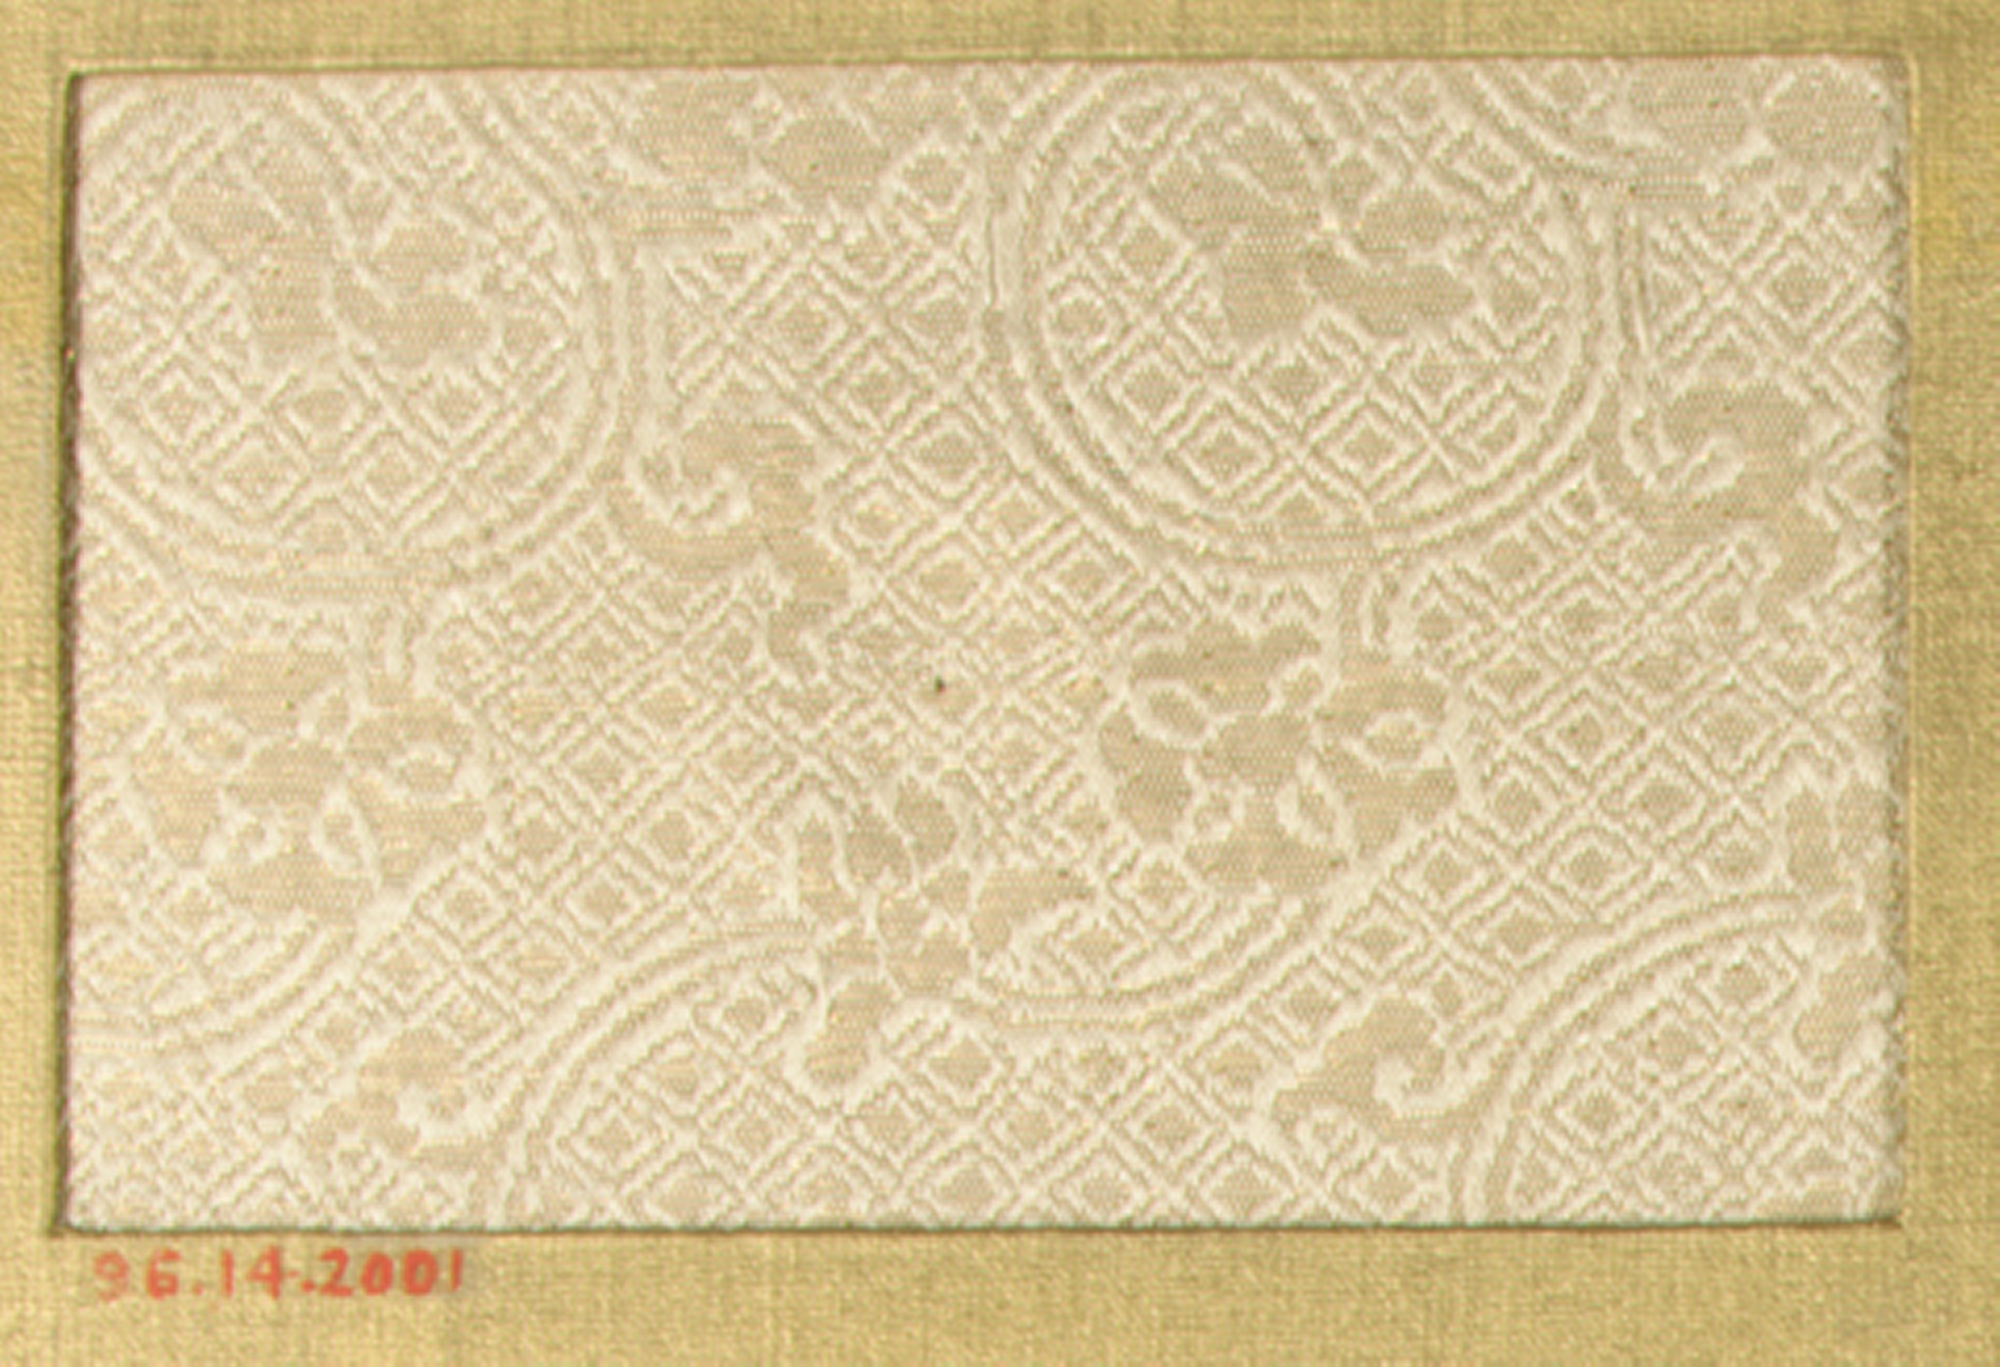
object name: piece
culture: japanese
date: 1701-1900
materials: silk